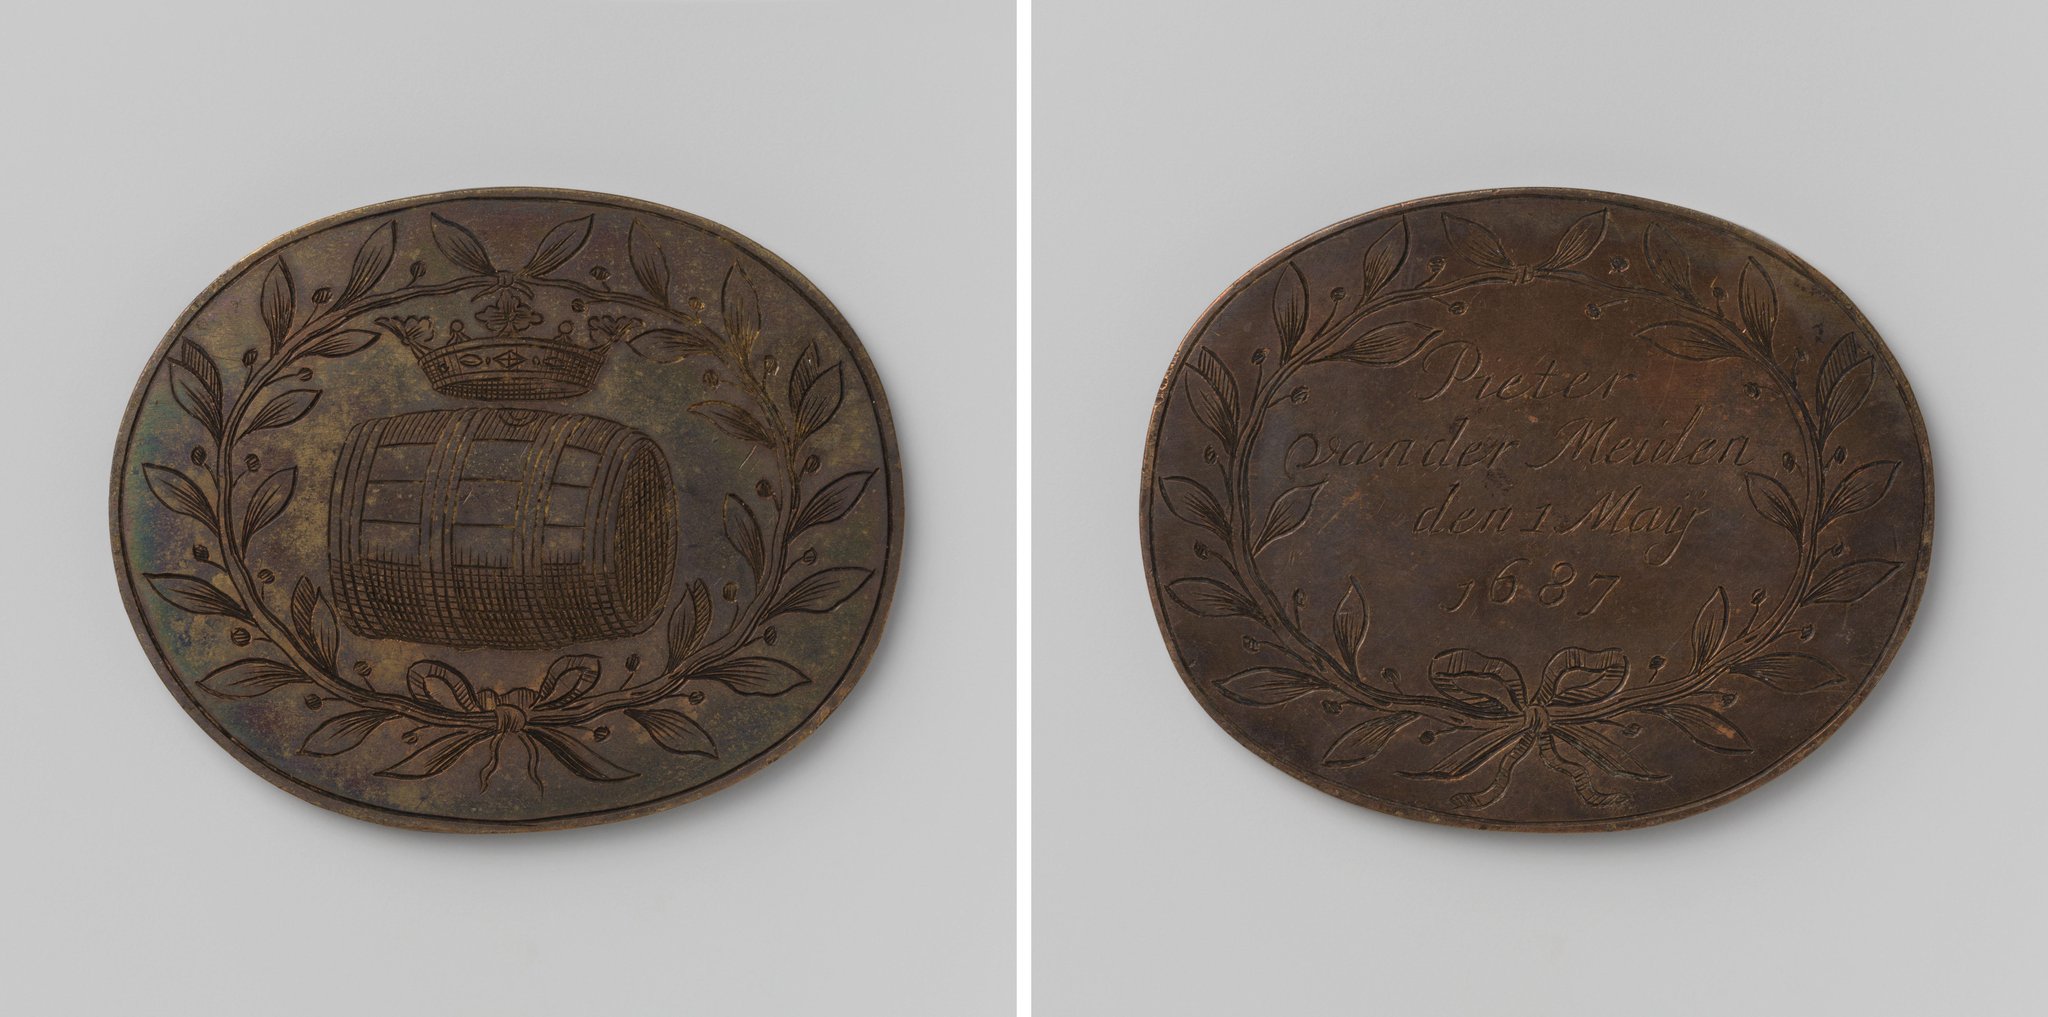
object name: medal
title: Bierbeschooiersgilde van Amsterdam, gildepenning van Pieter van der Meulen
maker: Anonymous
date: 1687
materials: copper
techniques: engraving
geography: amsterdam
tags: amsterdam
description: Guilds were urban organisations of people in specific occupations. The guild represented the interests of the profession. Each member had a token as proof of membership. The person’s name was engraved on one side of the token, often together with the arms of the guild or of the city in which it was based. The other side carried a motif signifying the occupation represented by the guild.